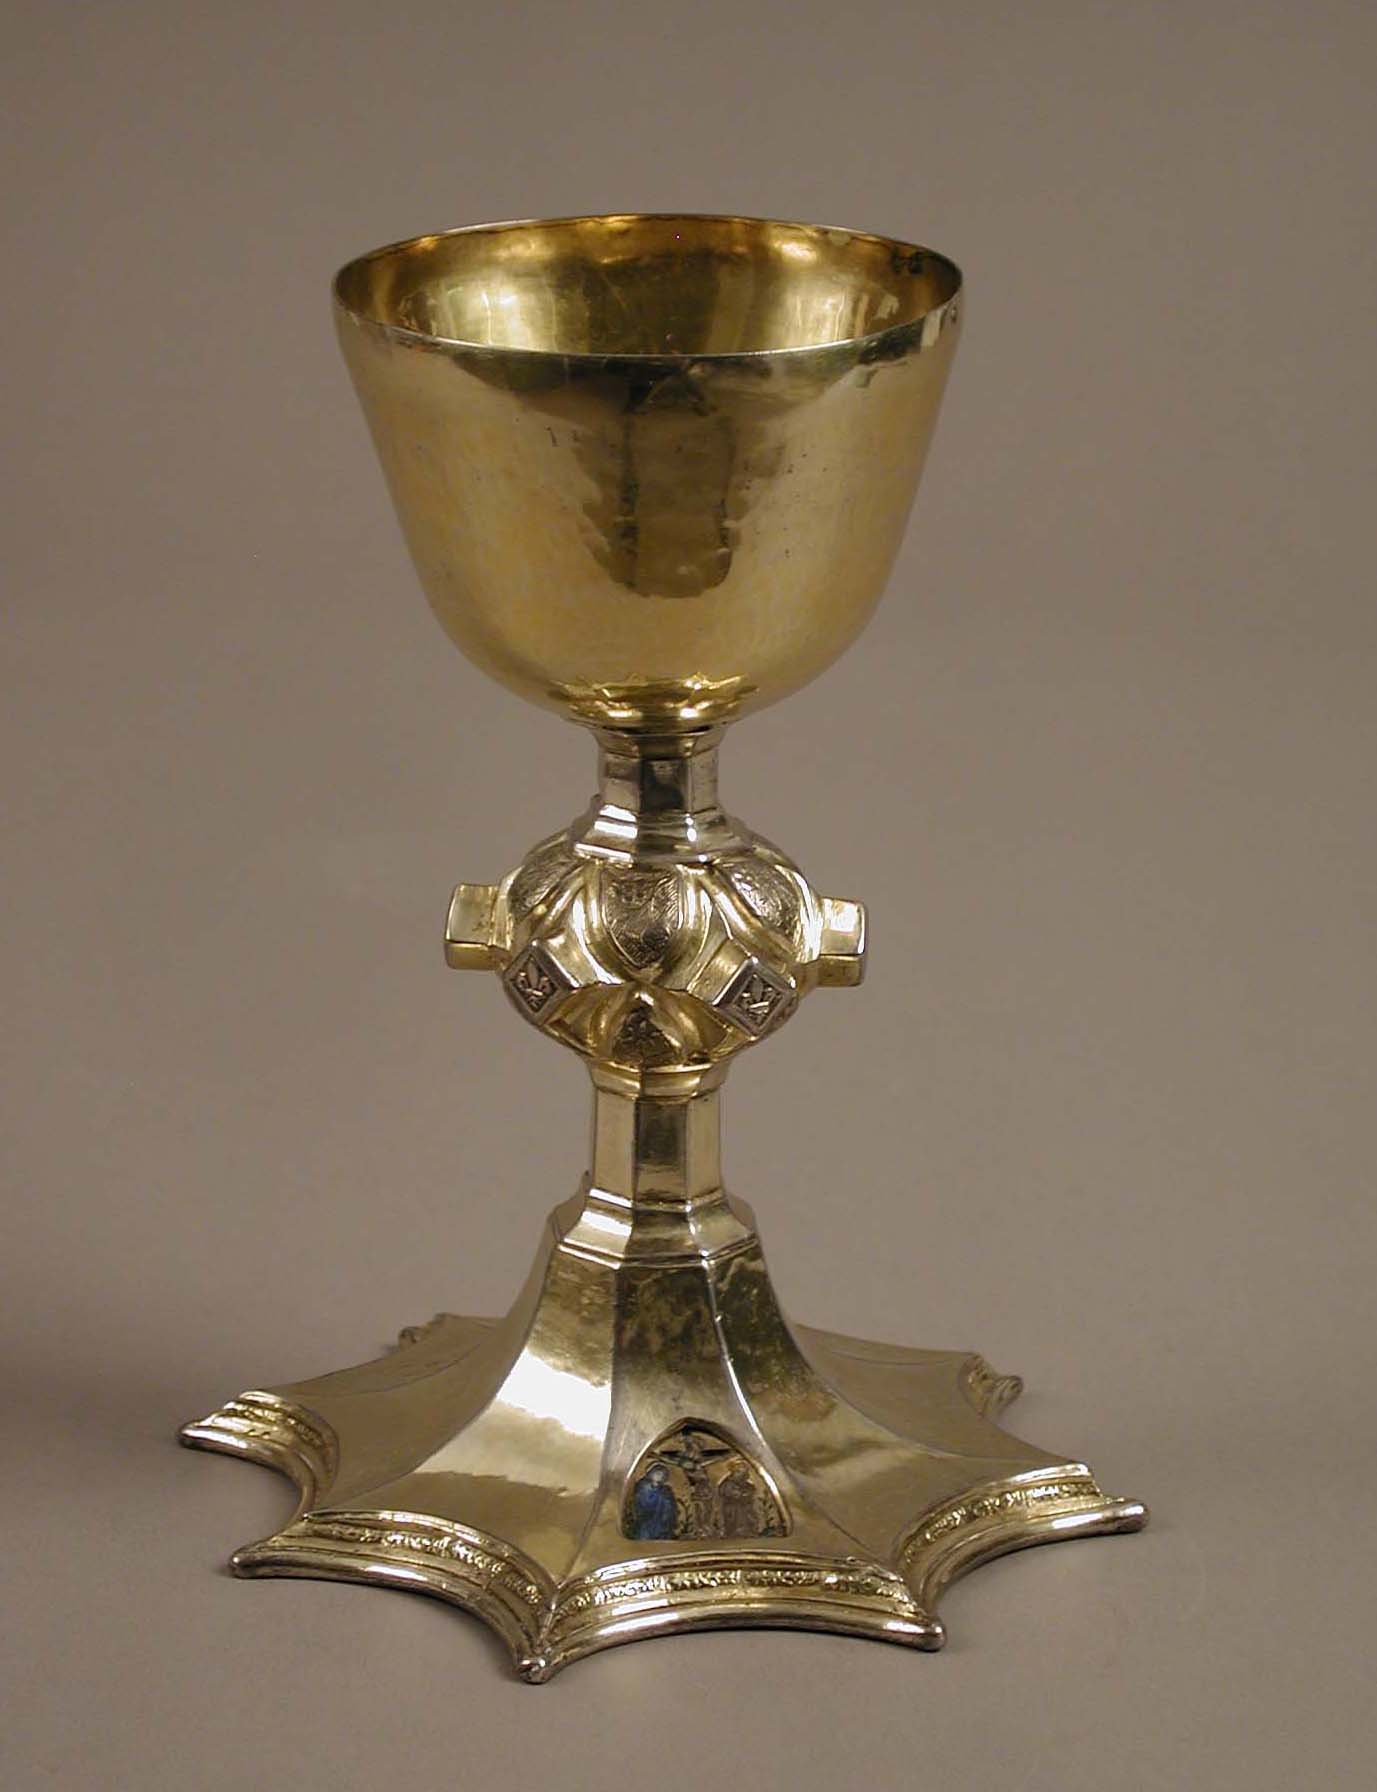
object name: chalice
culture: french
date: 1434-1466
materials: enamel, gilt, niello, silver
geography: france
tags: christ,crucifixion,insignia